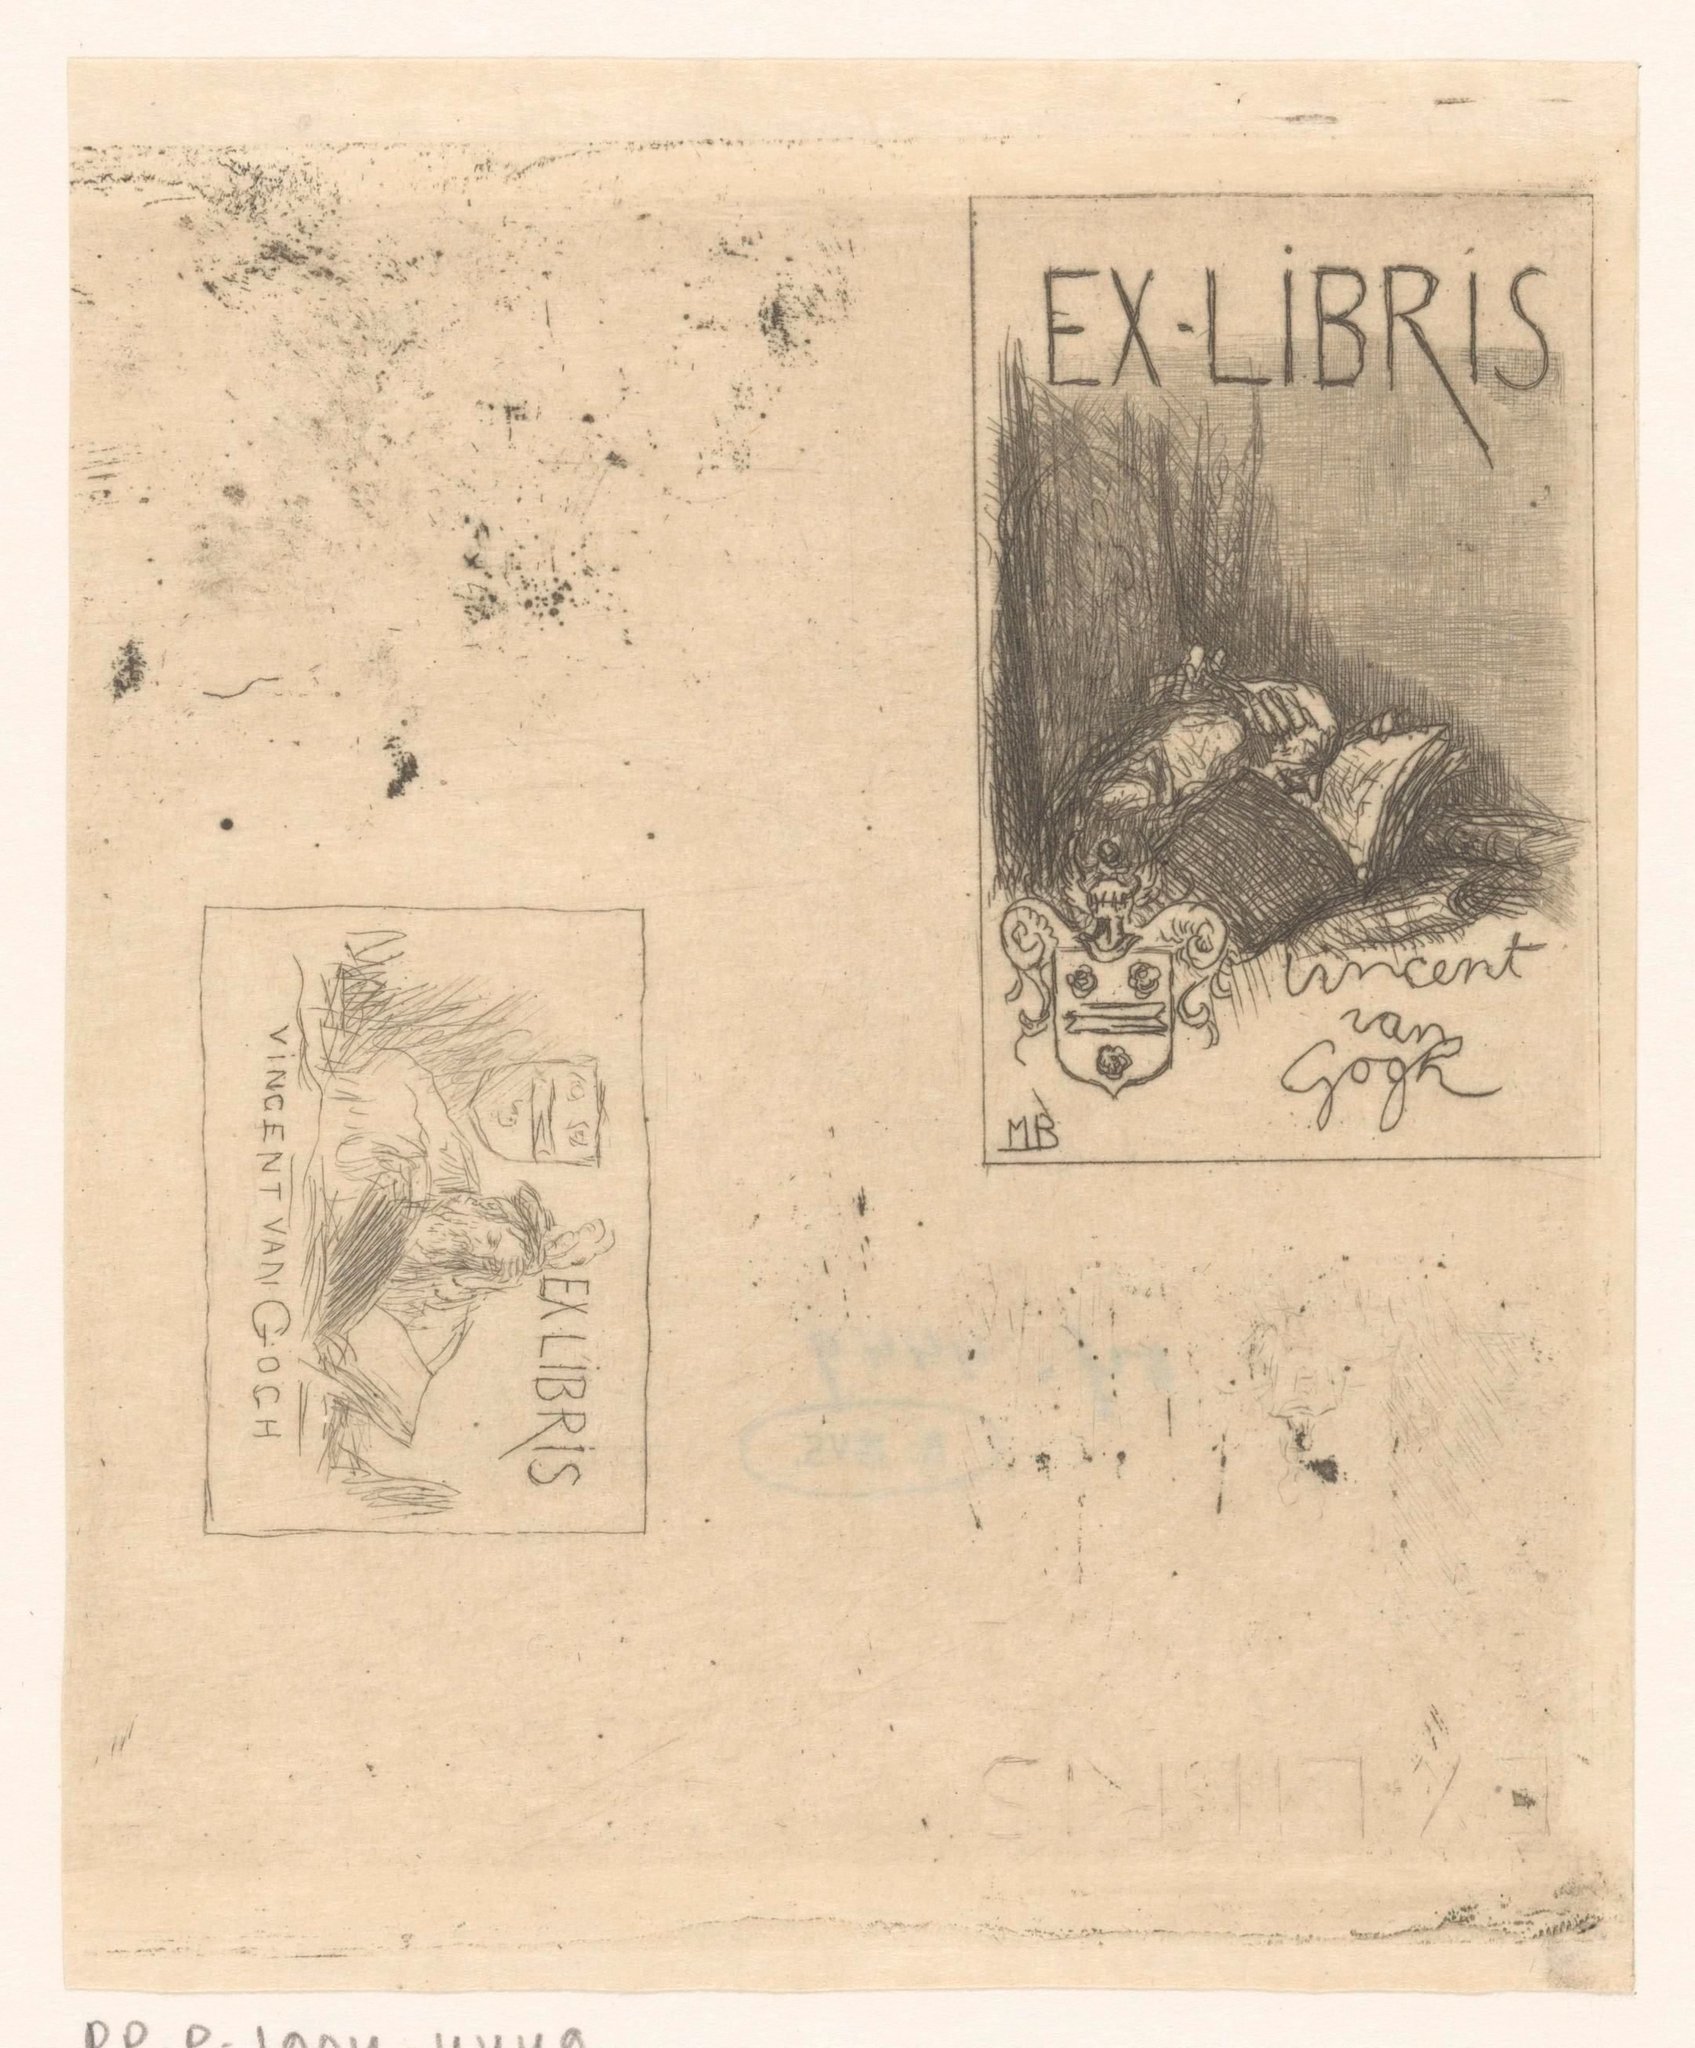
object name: print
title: Twee ex librissen voor Vincent van Gogh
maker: marius bauer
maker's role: draughtsman, print maker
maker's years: 1867-1932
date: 1877-1904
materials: paper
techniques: etching, intaglio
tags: amsterdam, reading, ex-libris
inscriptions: collector's mark: Lugt 2228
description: Twee ex librissen voor kunsthandelaar Vincent van Gogh, met op elk een lezende man en een wapenschild.